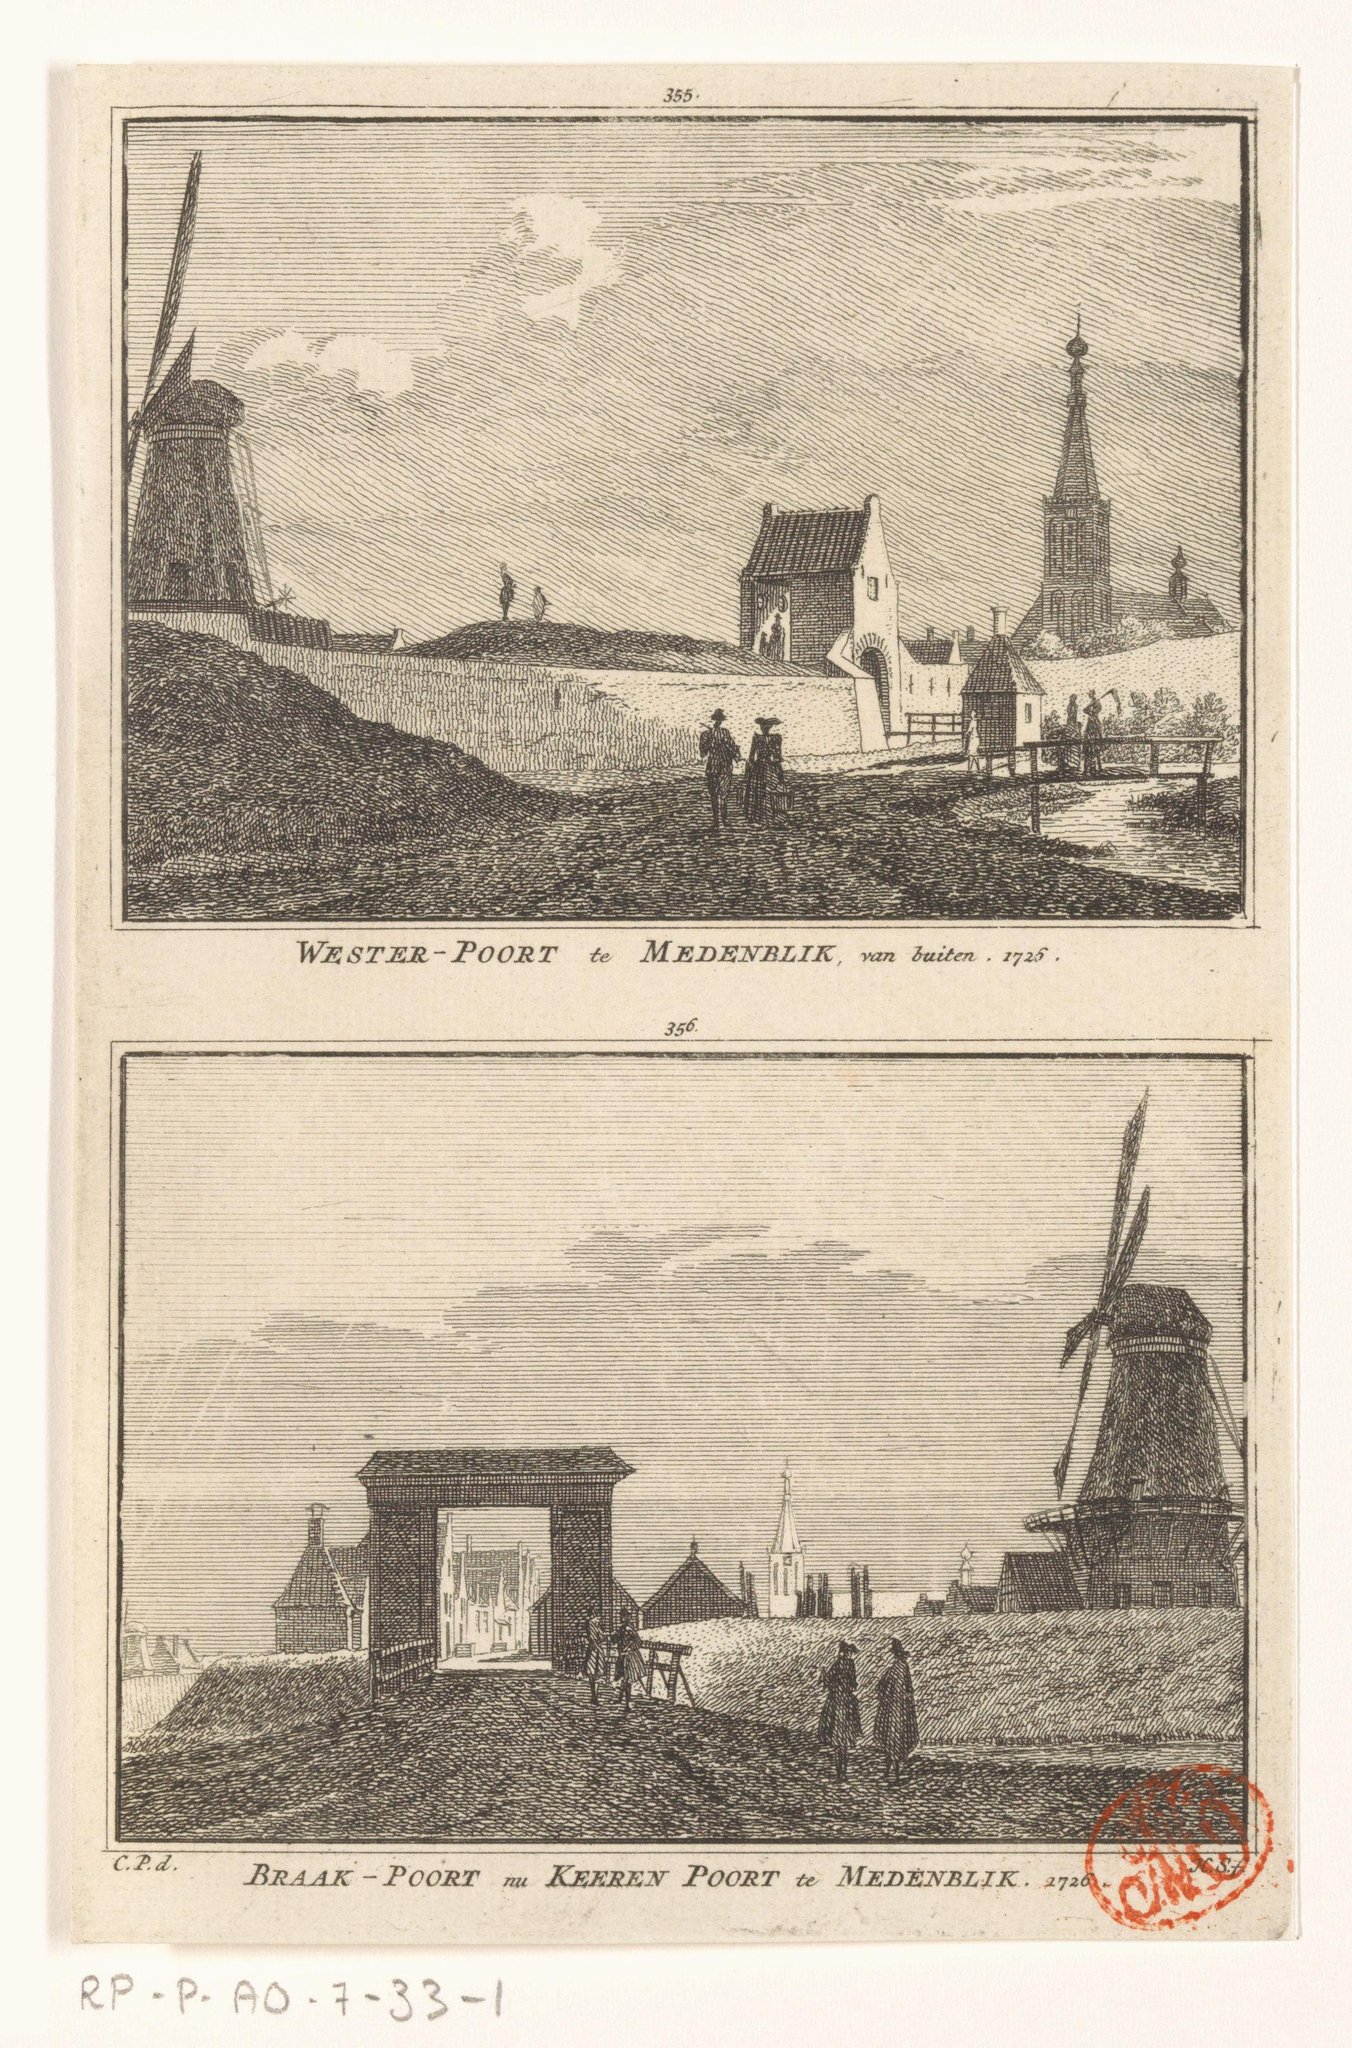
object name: print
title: Gezicht op de Westerpoort en gezicht op de Braak- of Keerenpoort te Medemblik, 1726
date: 1752-1792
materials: paper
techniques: engraving, etching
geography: haarlem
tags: windmill, city-gate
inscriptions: collector's mark: Lugt 195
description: Prent ook gebruikt in: Het verheerlykt Nederland of kabinet van hedendaagsche gezigten van steden, dorpen (…). 9 delen. Amsterdam: Isaak Tirion en weduwe Isaak Tirion, 1745-1774, dl. 4 (1752), ill. 355 en 356. Of in: Nederlandsche tafereelen; of eene keurige verzameling van negen honderd fraaije gezigten van steden, dorpen, sloten, oudheden (….). 9 delen. Amsterdam: Jan de Groot, 1792, dl. 4, ill. 355 en 356. Uit welke druk het huidige exemplaar precies komt is niet na te gaan.